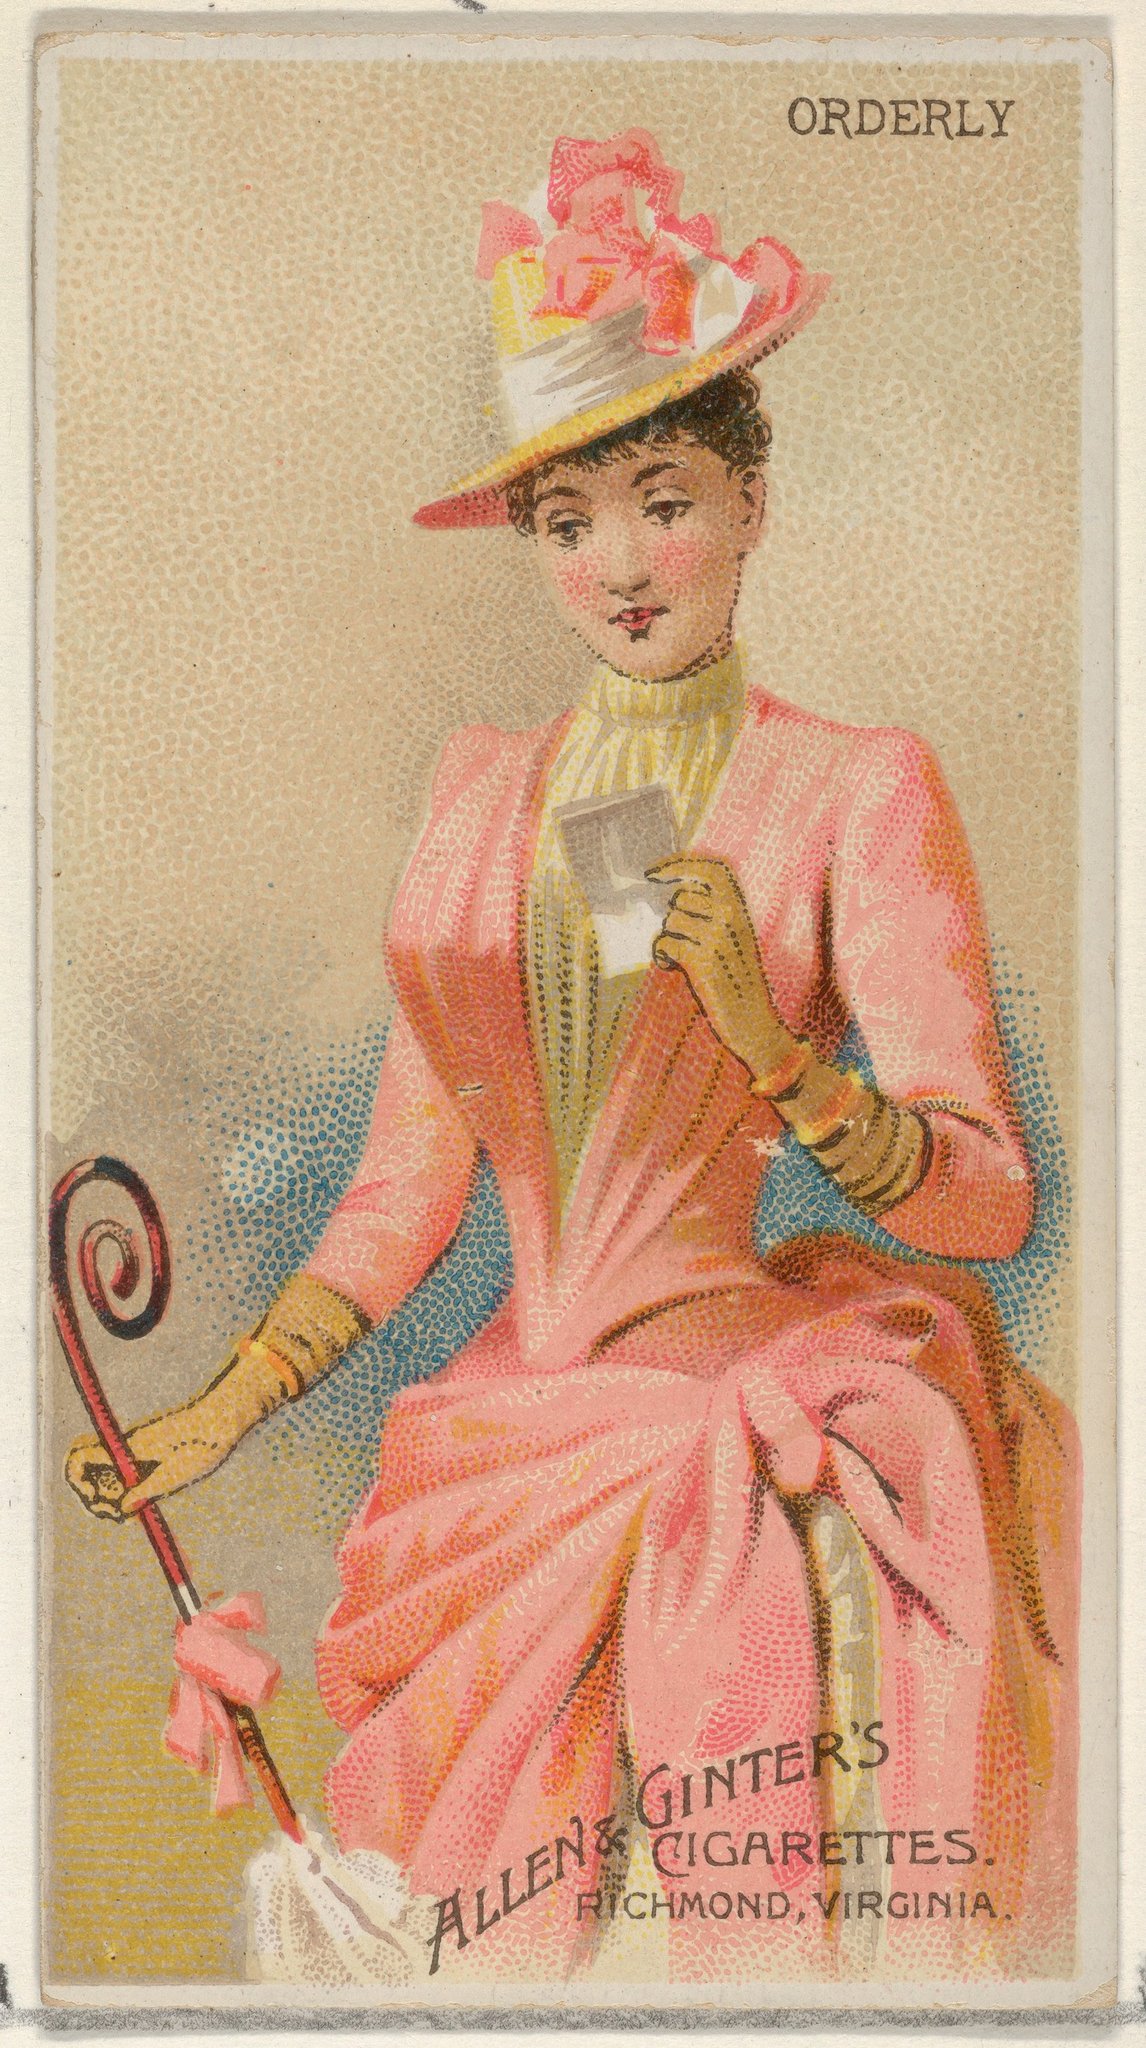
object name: print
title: Orderly, from the Parasol Drills series (N18) for Allen & Ginter Cigarettes Brands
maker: allen & ginter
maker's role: publisher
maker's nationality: american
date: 1888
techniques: color lithograph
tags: women